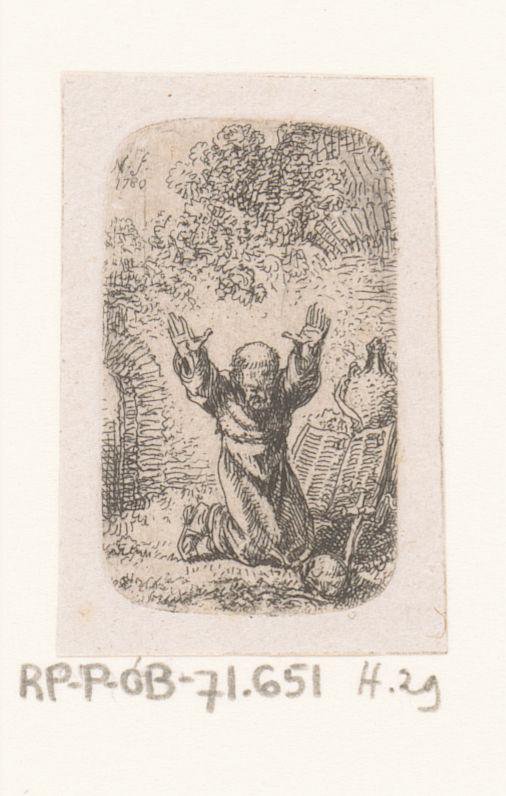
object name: print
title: Geknielde monnik met armen omhoog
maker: jean pierre norblin de la gourdaine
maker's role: print maker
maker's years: 1745-1830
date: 1780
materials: paper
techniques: etching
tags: monk(s), friar(s), one person praying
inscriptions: collector's mark: Lugt 2228